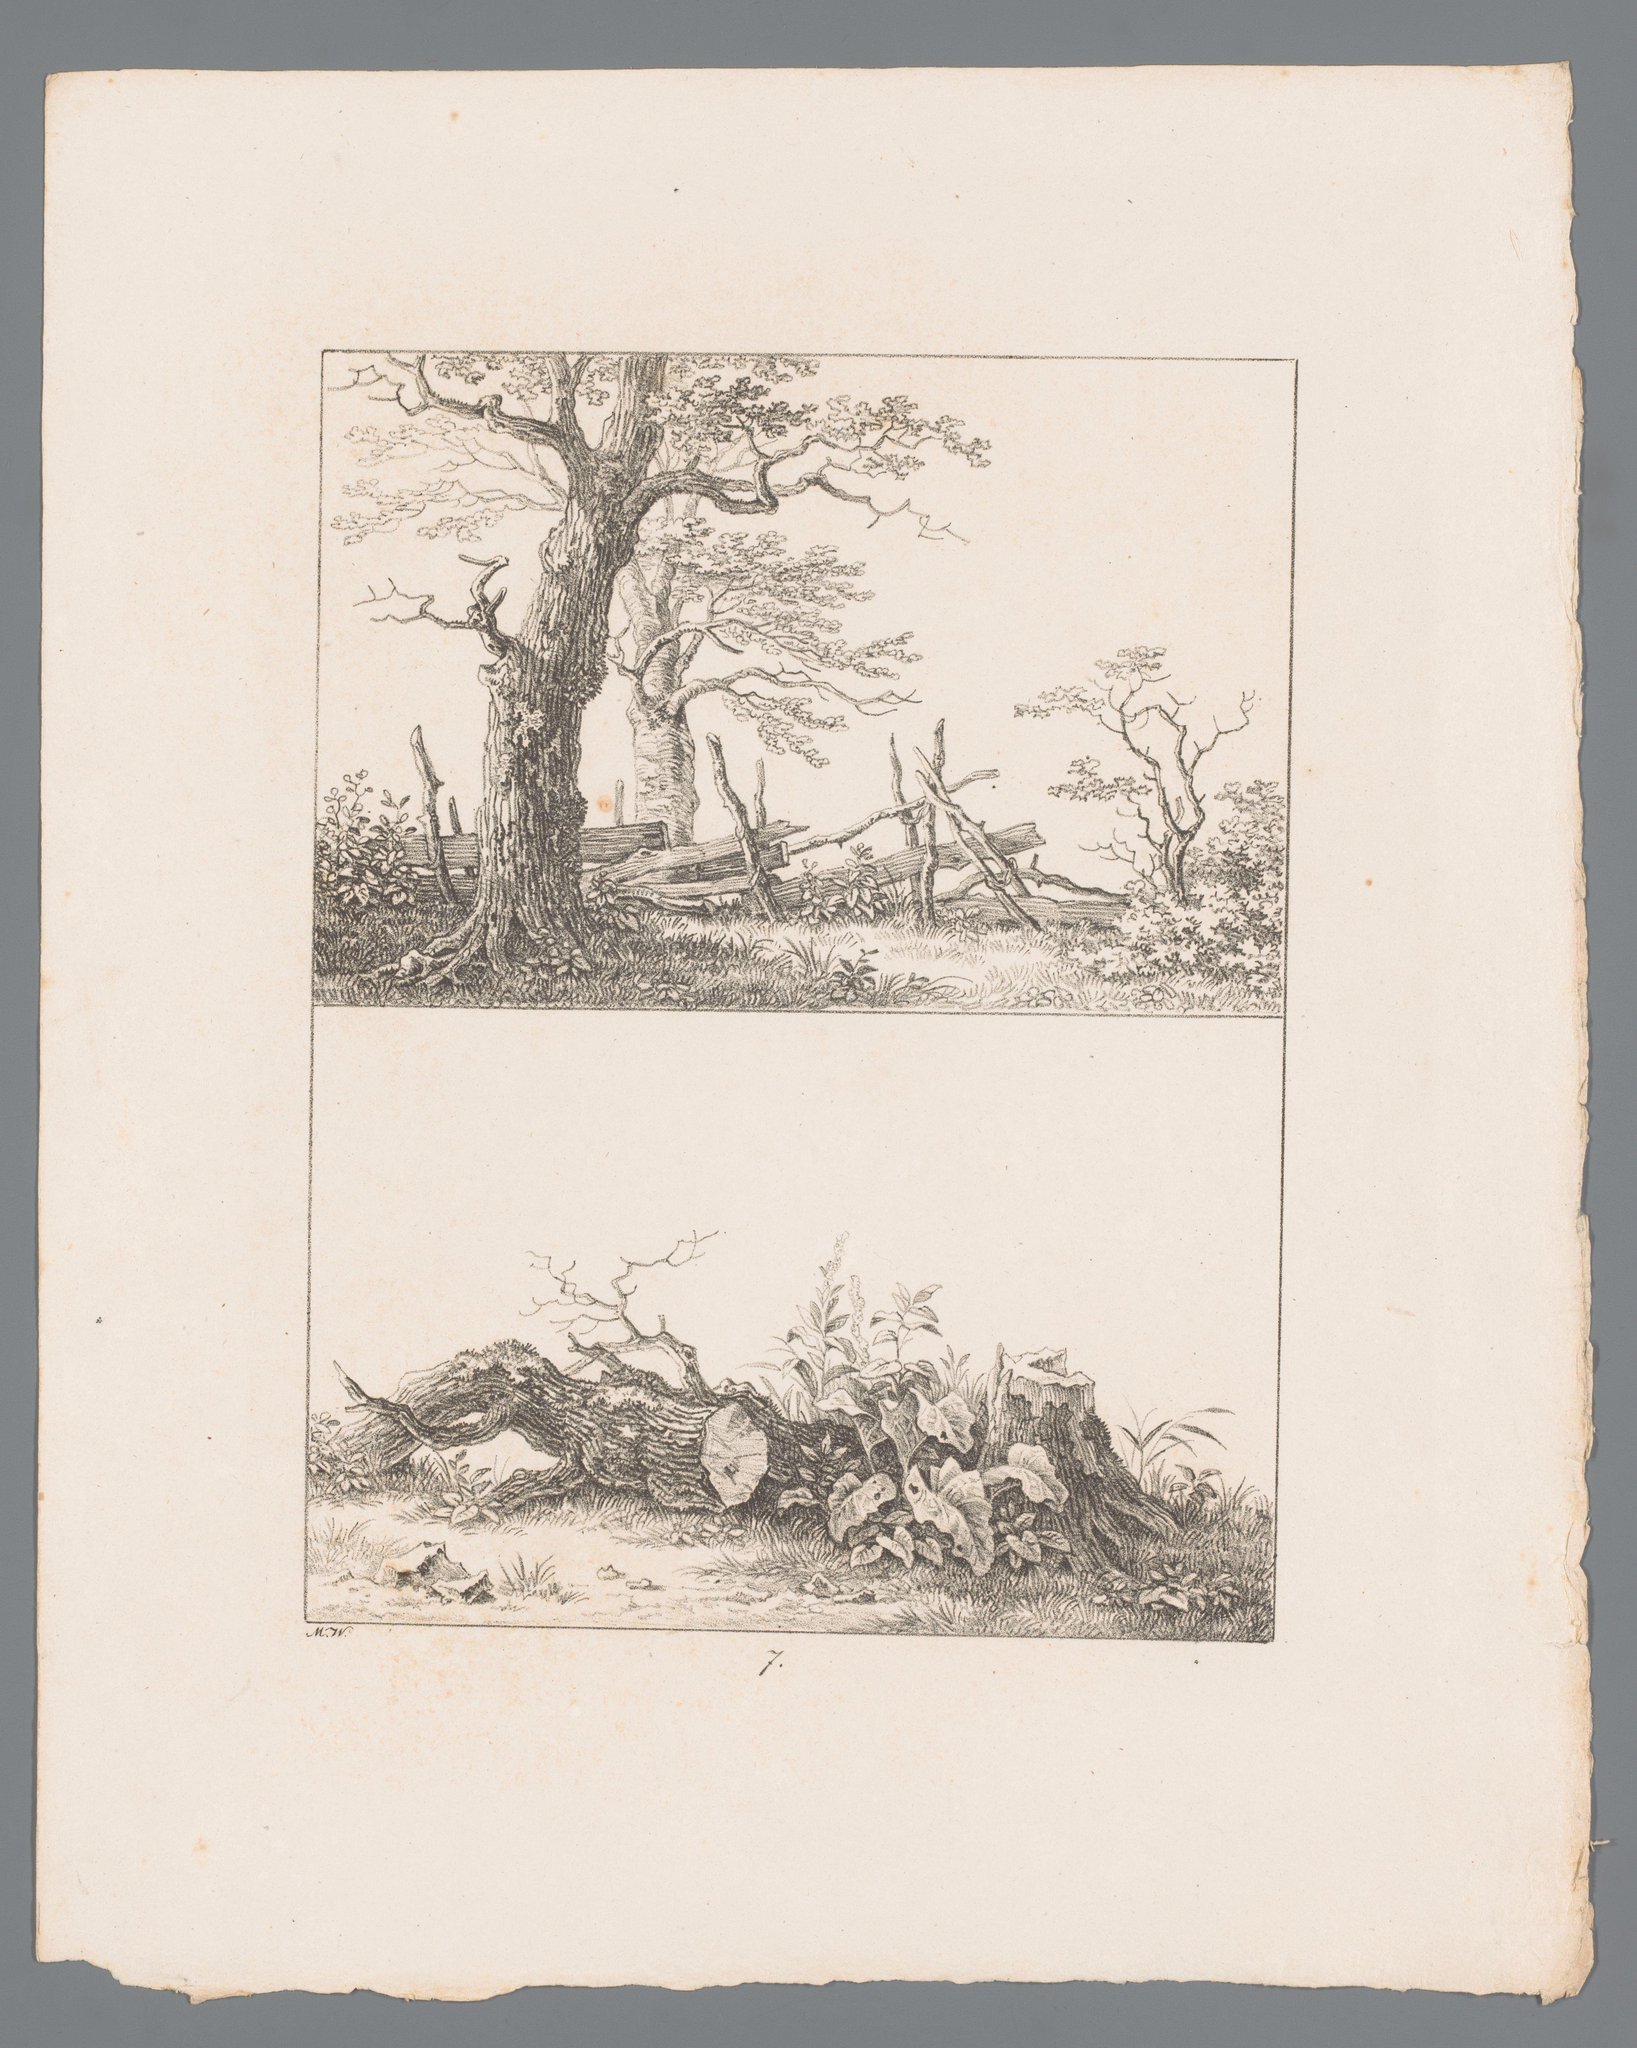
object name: print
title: Vorlagen für Landschaft-Zeichner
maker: max josef wagenbauer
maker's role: print maker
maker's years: 1774-1829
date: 1823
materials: paper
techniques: lithograph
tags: trees, fence, wall, paling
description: Onderdeel van een tweedelige serie waarvan het eerste deel bestaat uit een titelprent en twintig voorstellingen van takken, bladeren, bomen en landschappen.